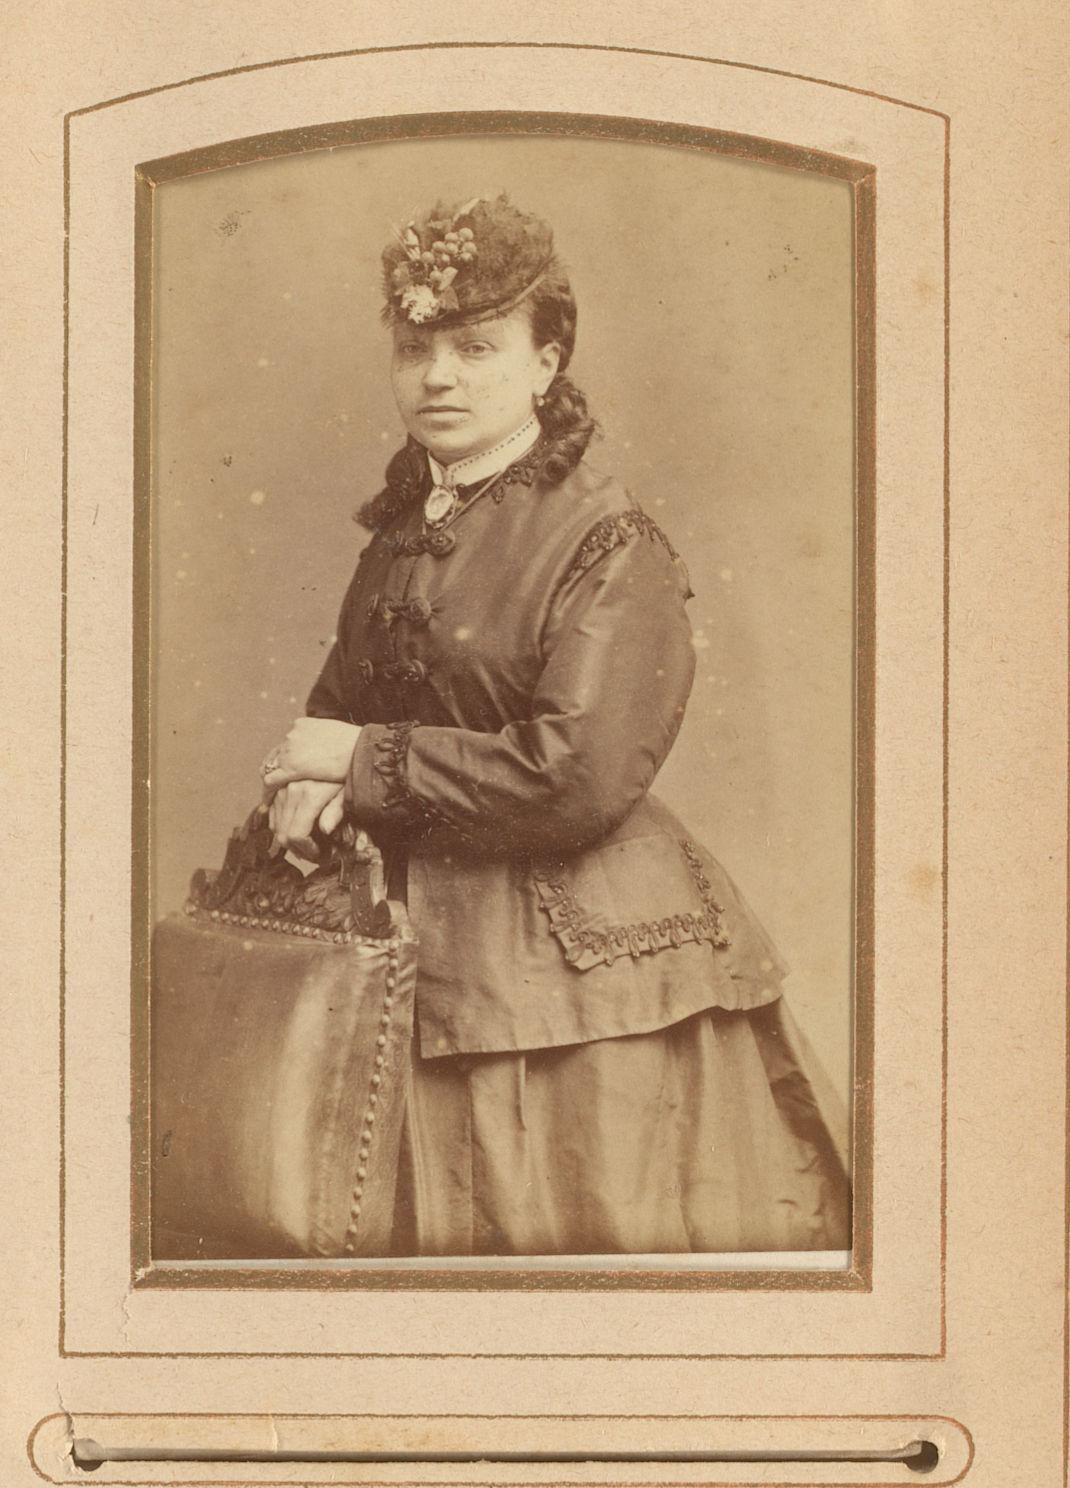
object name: album leaf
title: Portret van een onbekende vrouw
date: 1880-1884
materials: cardboard, paper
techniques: albumen print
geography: amsterdam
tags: anonymous historical person portrayed - bb - woman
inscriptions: address: ‘KALVERSTRAAT/ over den Heyligenweg, D.26./ AMSTERDAM/ LEYDSCHE STRAATWEG/ Buiten Cathrynen./ UTRECHT.’